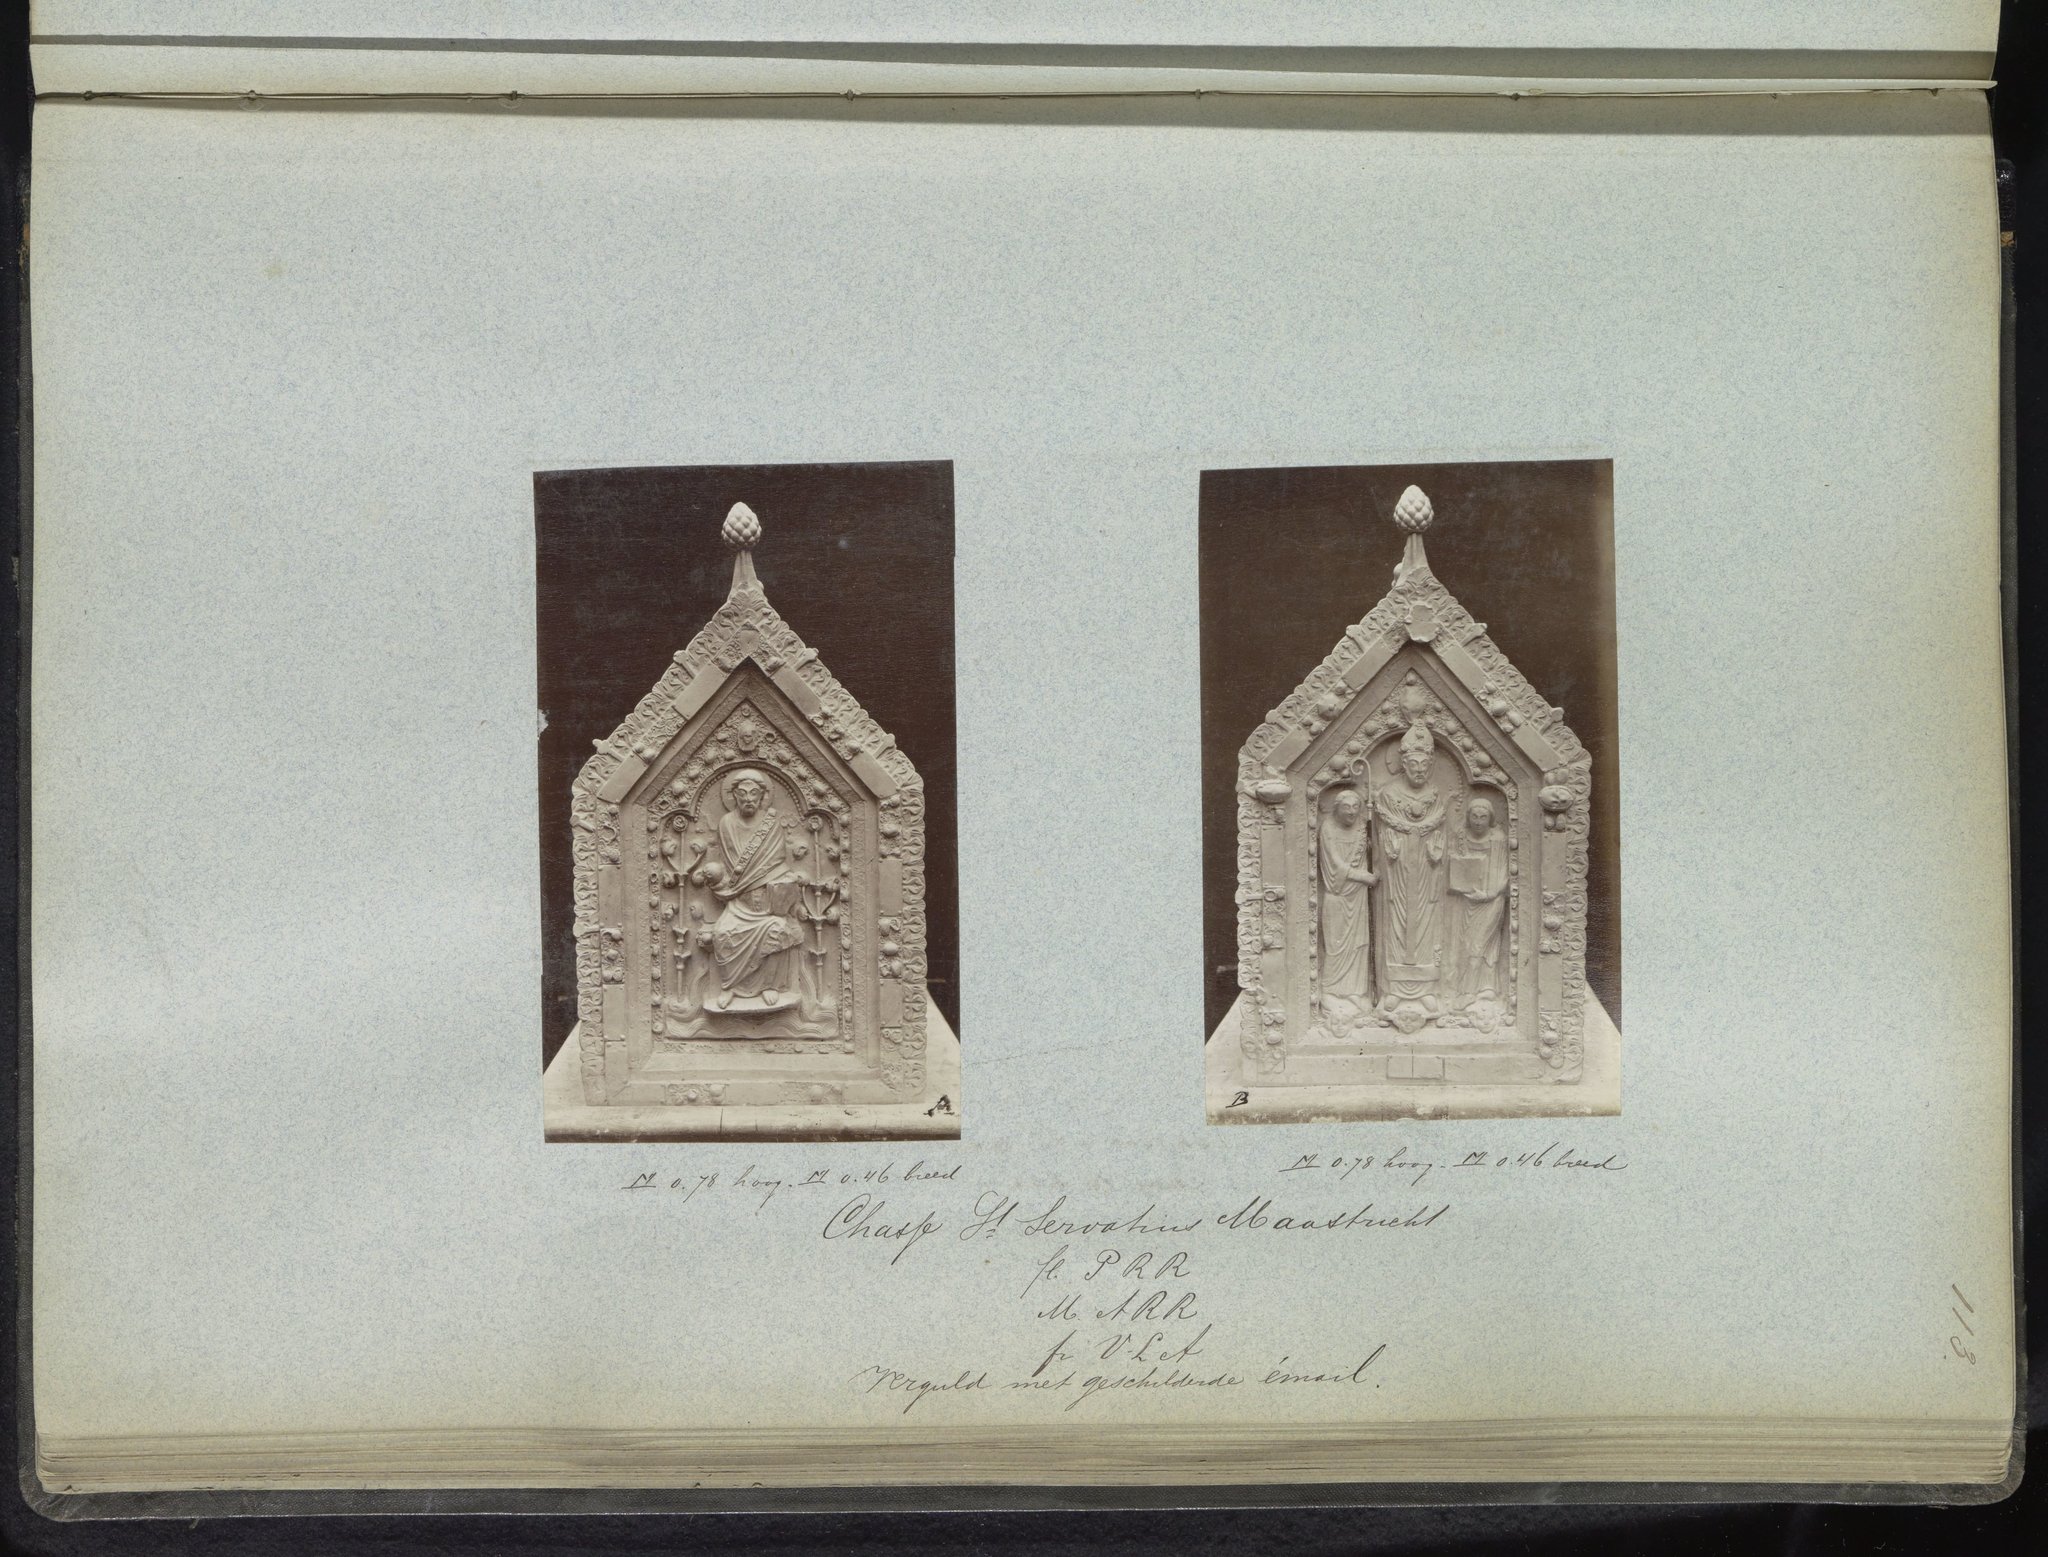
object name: album leaf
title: Gipsen afgietsel van een sculptuur uit de Sint-Servaasbasiliek te Maastricht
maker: Anonymous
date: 1875-1900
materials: paper, photographic support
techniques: albumen print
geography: maastricht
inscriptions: annotation: ‘[...] St. Servatius Maastricht’, annotation: ‘M 0.78 hoog M 0.46 breed’, annotation, annotation: ‘Verguld met geschilderd email’